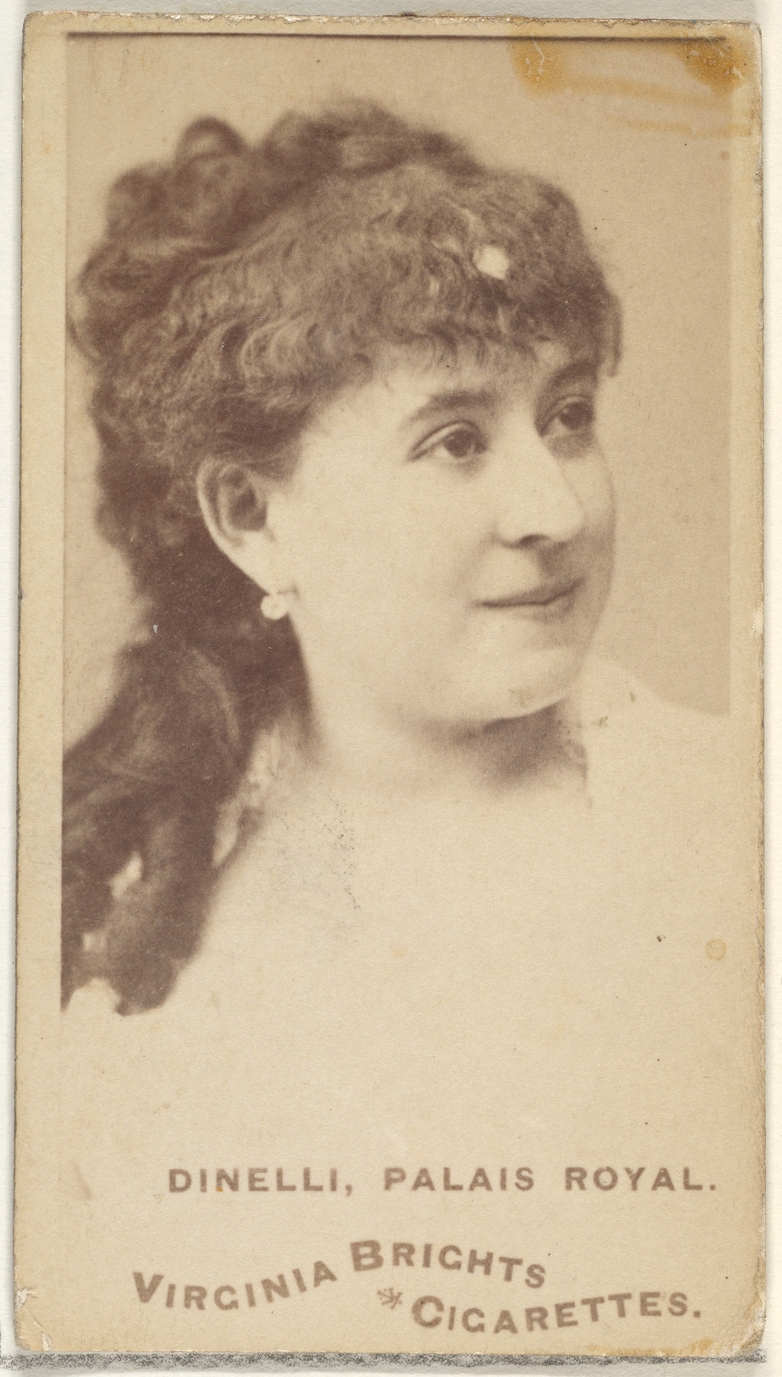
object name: photograph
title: Dinelli, Palais Royal, from the Actors and Actresses series (N45, Type 1) for Virginia Brights Cigarettes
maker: allen & ginter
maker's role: publisher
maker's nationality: american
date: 1888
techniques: albumen silver print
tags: portraits,women,actresses